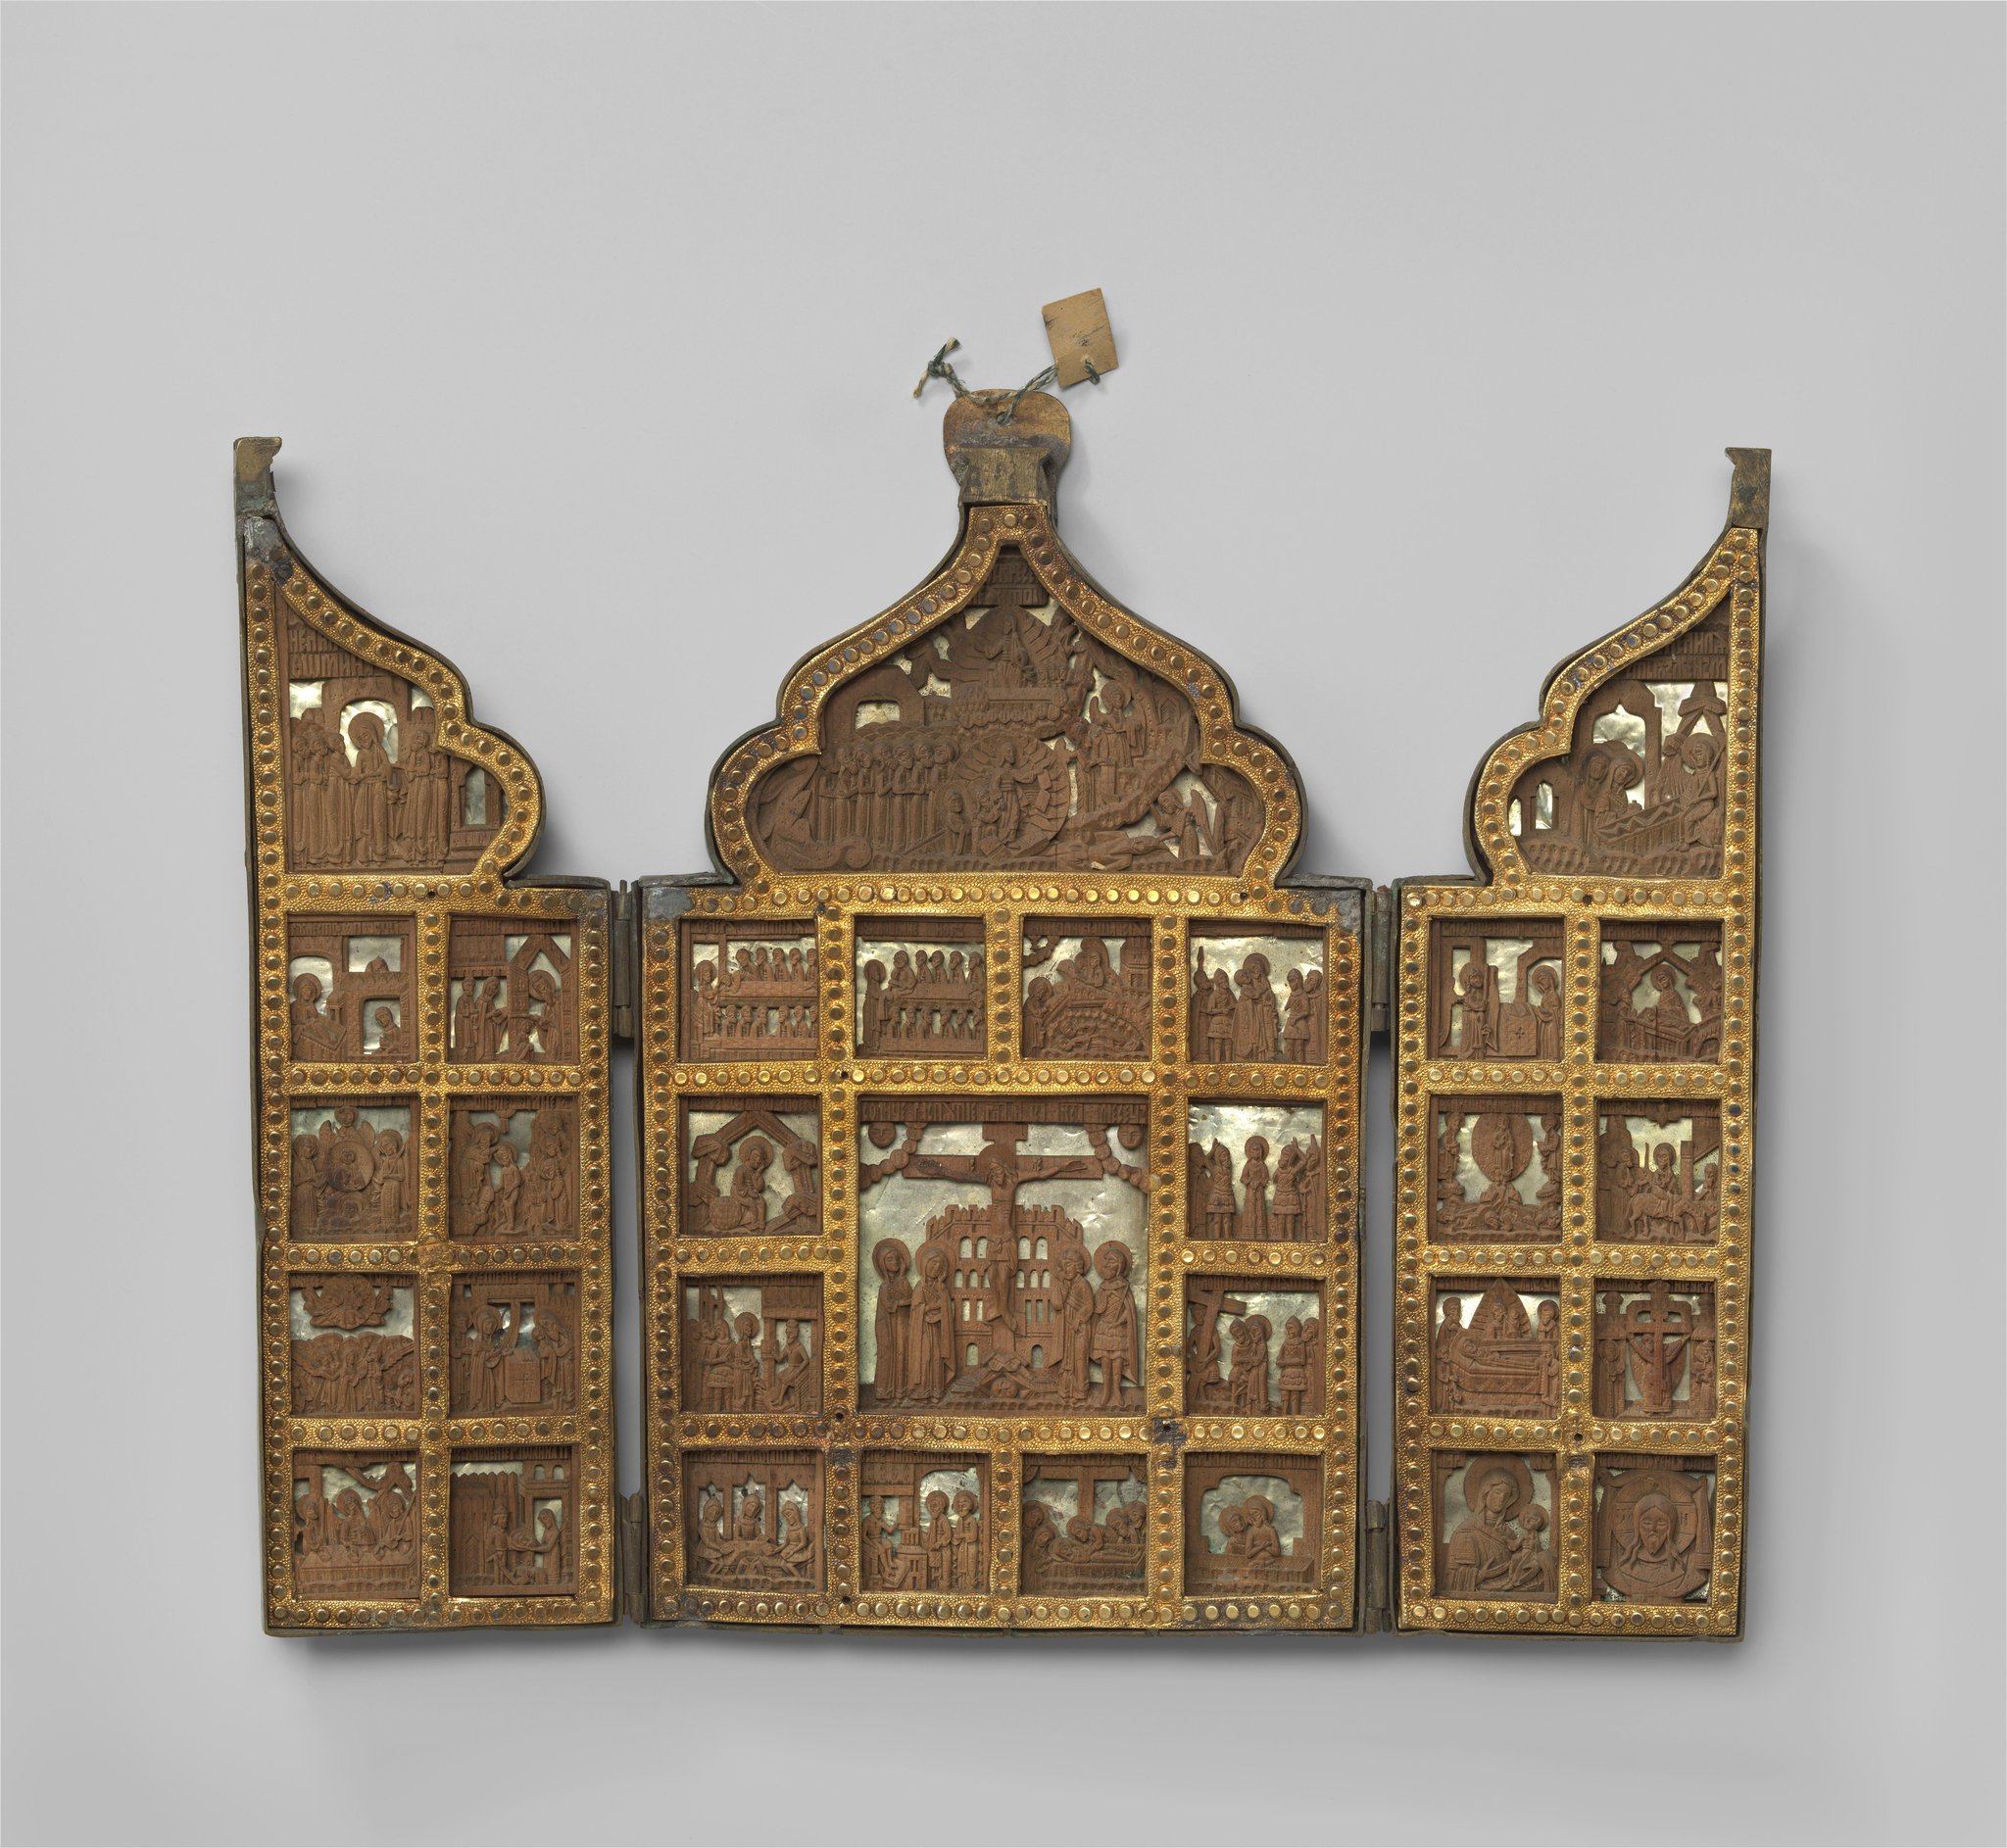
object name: triptych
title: Triptiek van palmhout met scènes uit het leven van Christus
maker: Anonymous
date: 1700-1900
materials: brass, wood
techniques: cutting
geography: russia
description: Triptiek. 32 scènes uit het leven van Christus zijn gesneden in palmhout. Het middenpaneel is voorzien van glas. De omlijsting en afscheidingen van de scènes zijn van messing en versierd met een parelrand.